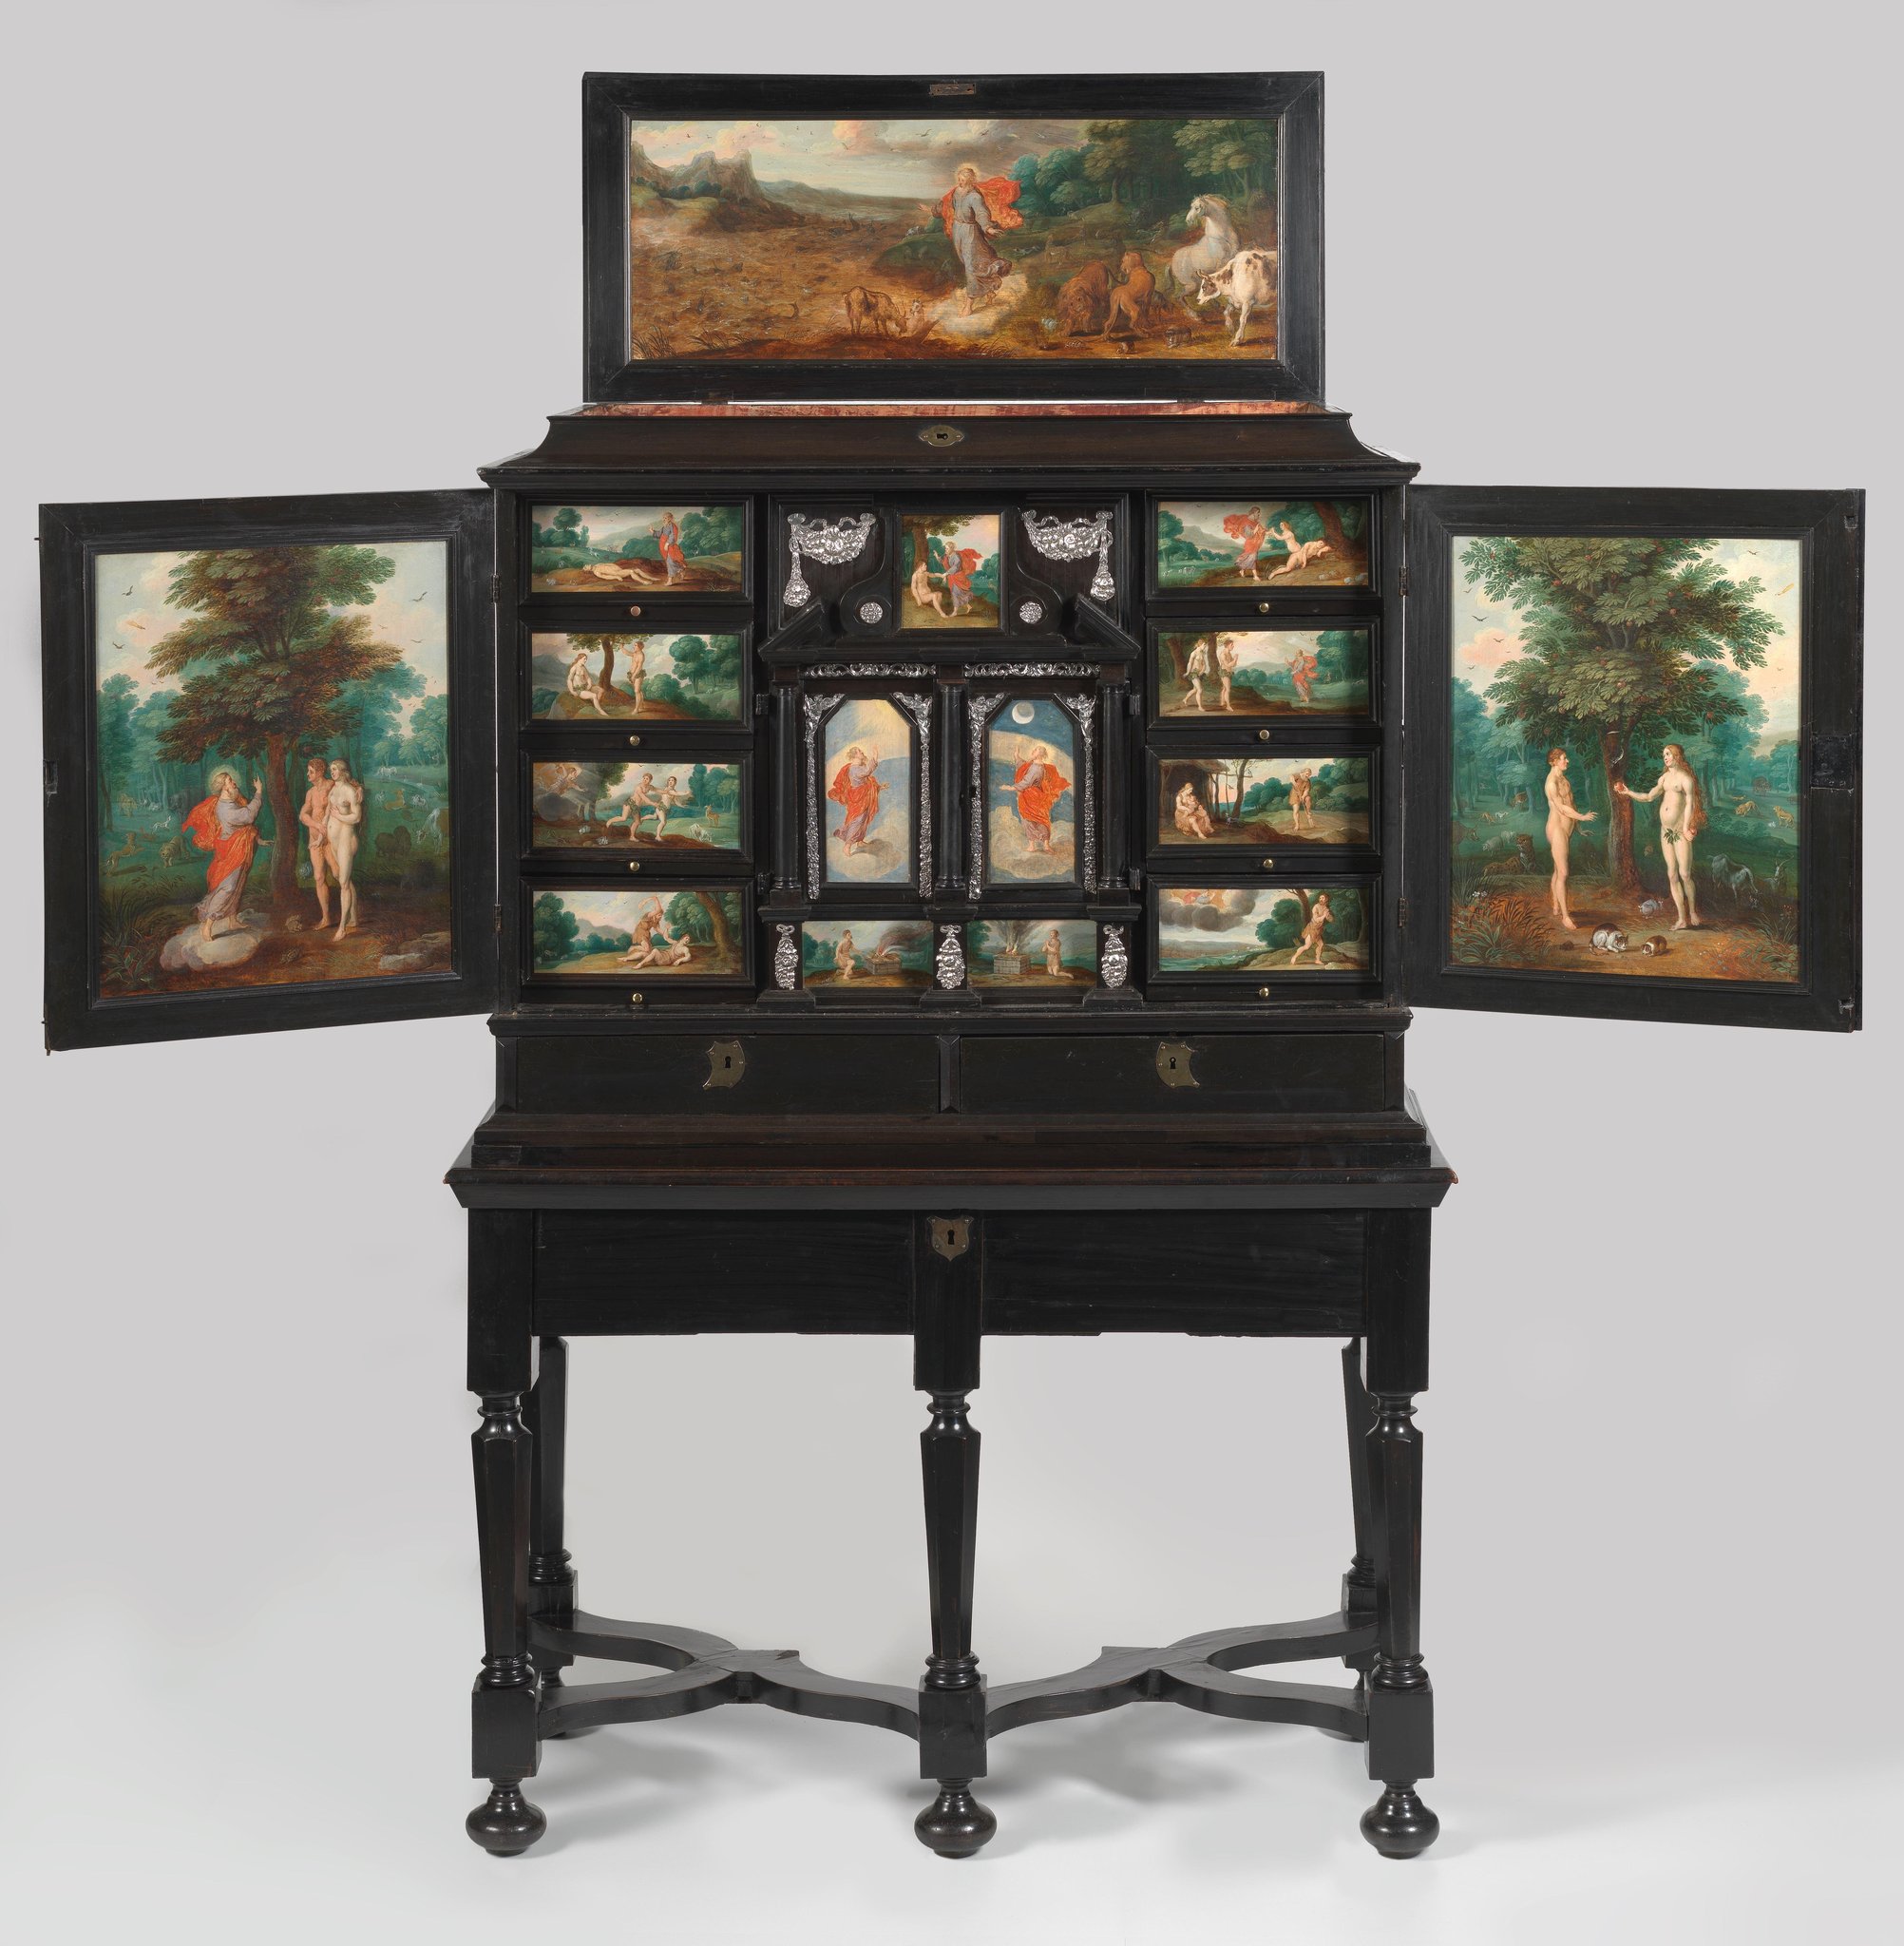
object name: collector's cabinet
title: Cabinet Decorated with Episodes from Genesis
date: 1640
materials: wood, glass, ivory, paint, silver, shell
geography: antwerp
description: Cabinet. Softwood, veneered with ebony, decorated with painted scenes from the book of Genesis. Antwerp, c. 1650.